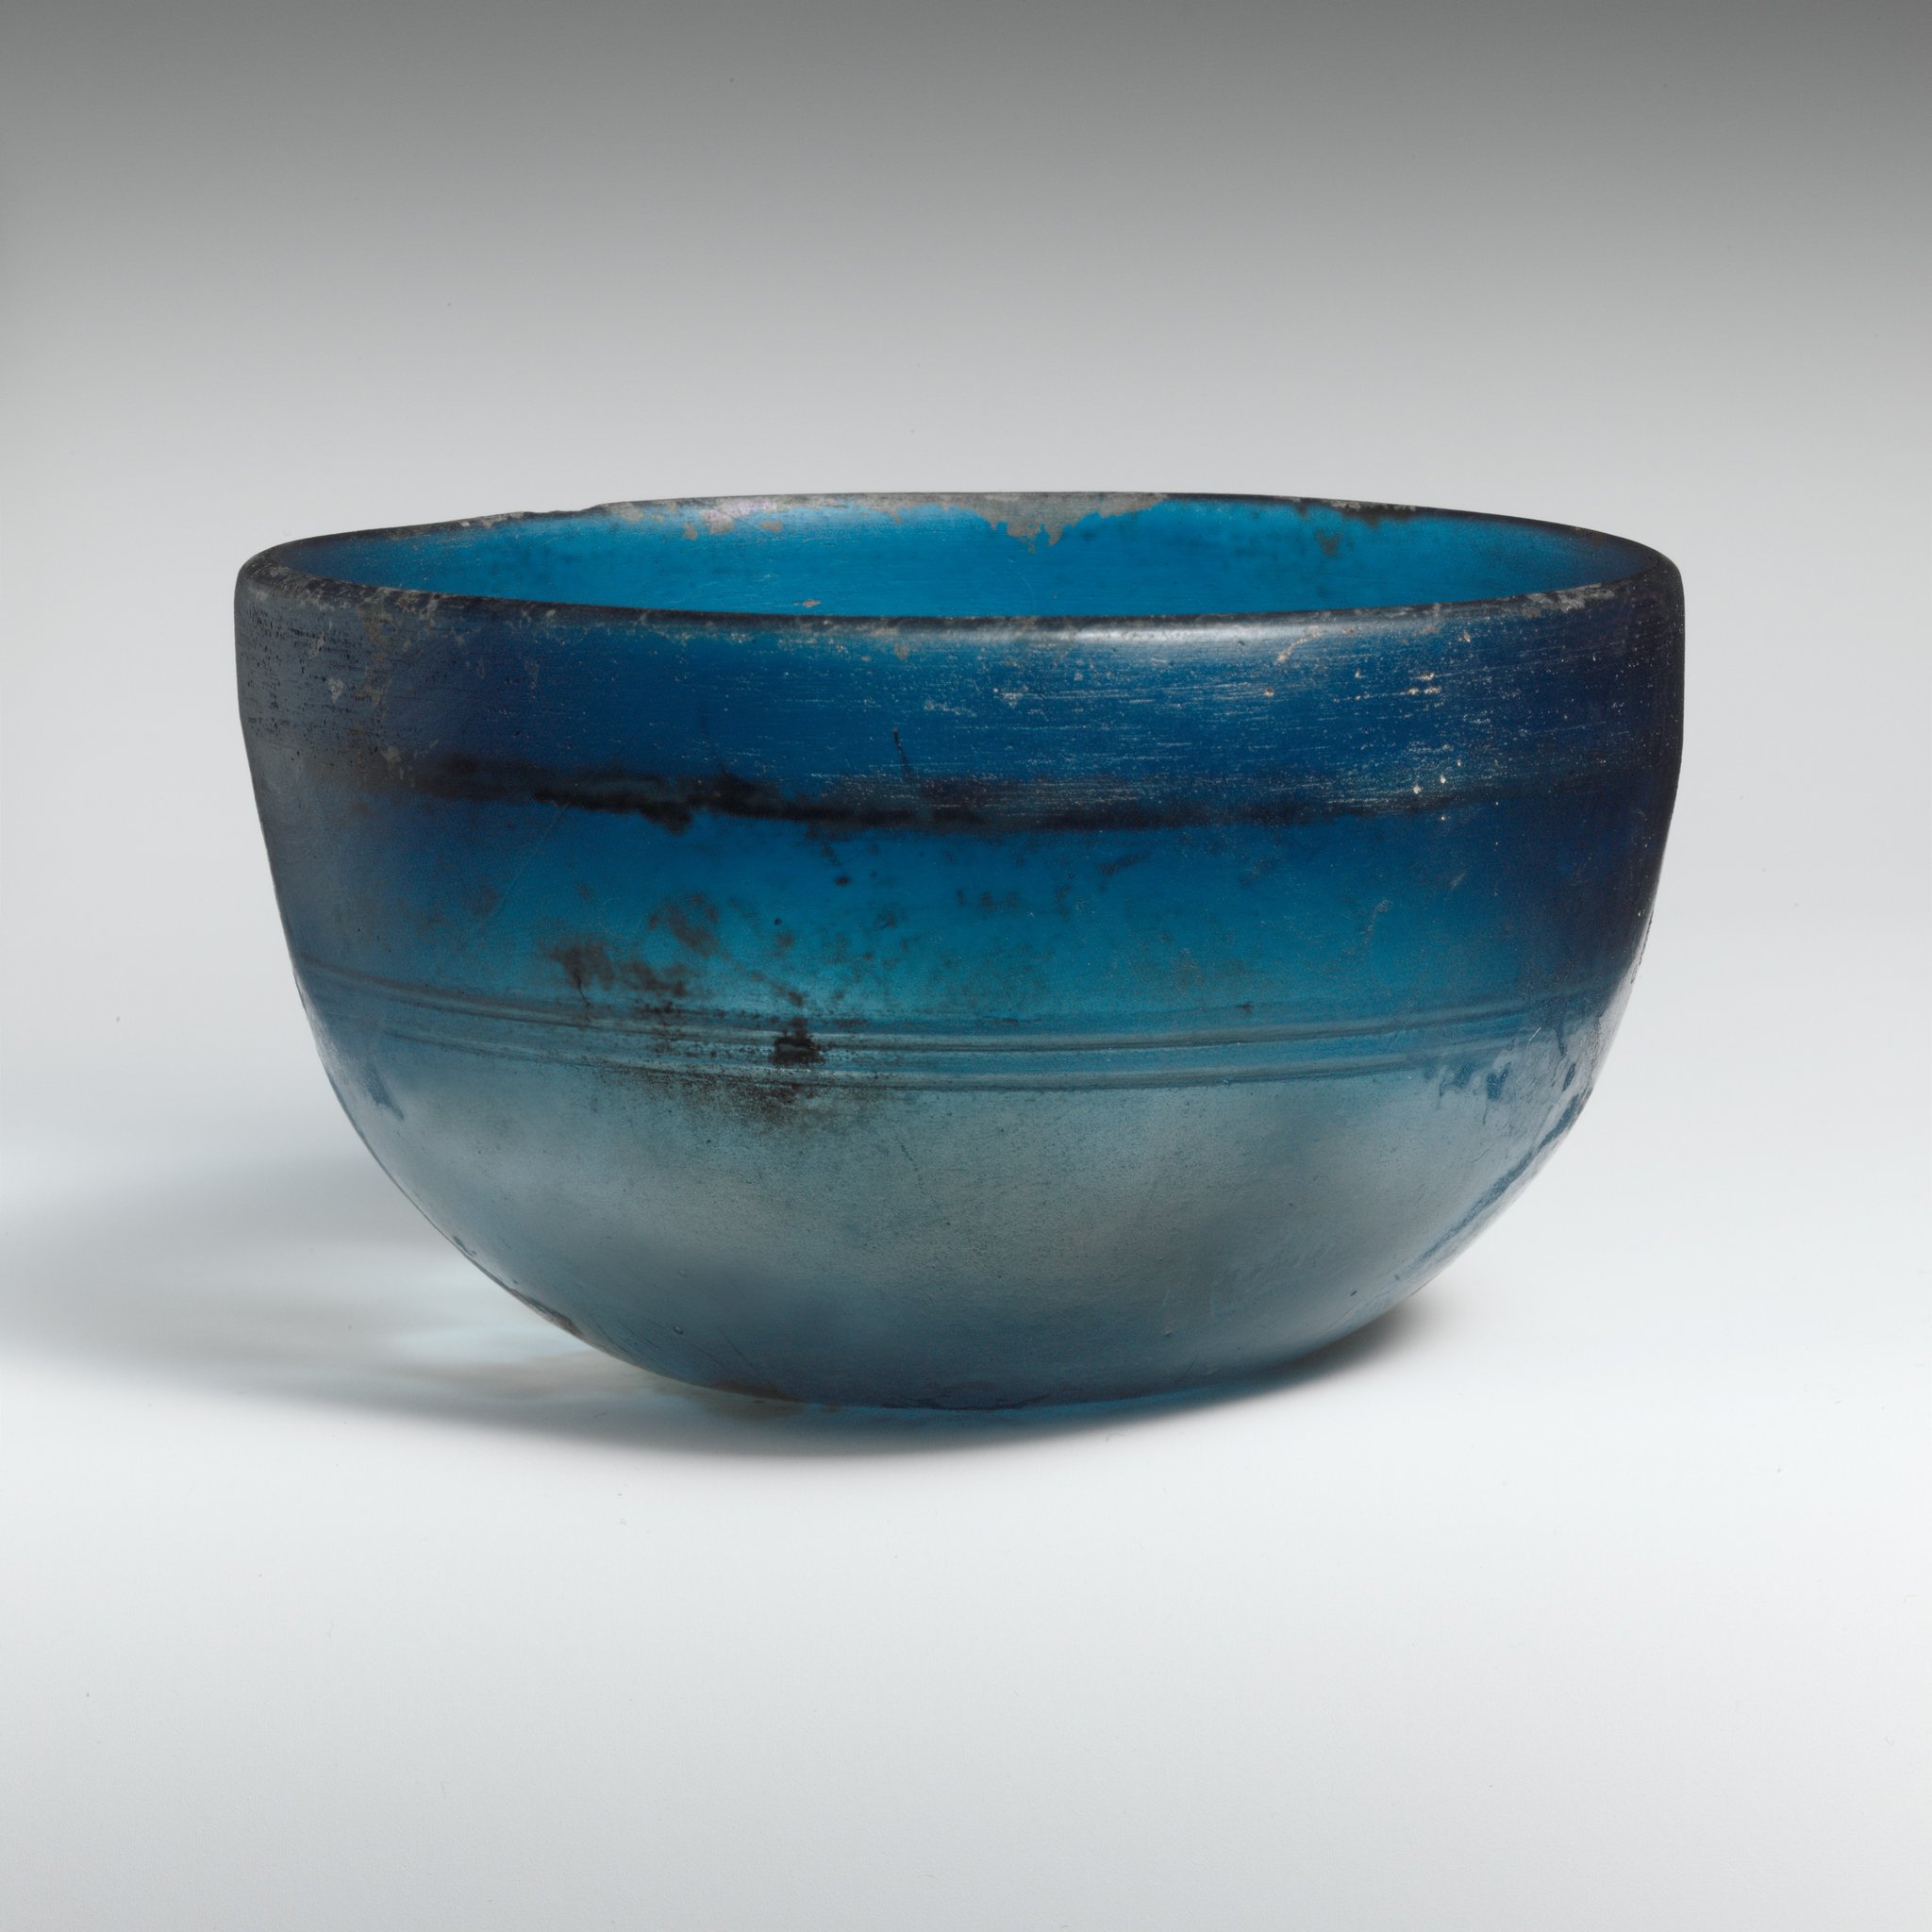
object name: bowl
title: Glass hemispherical bowl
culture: greek, eastern mediterranean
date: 100-1 BCE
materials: glass